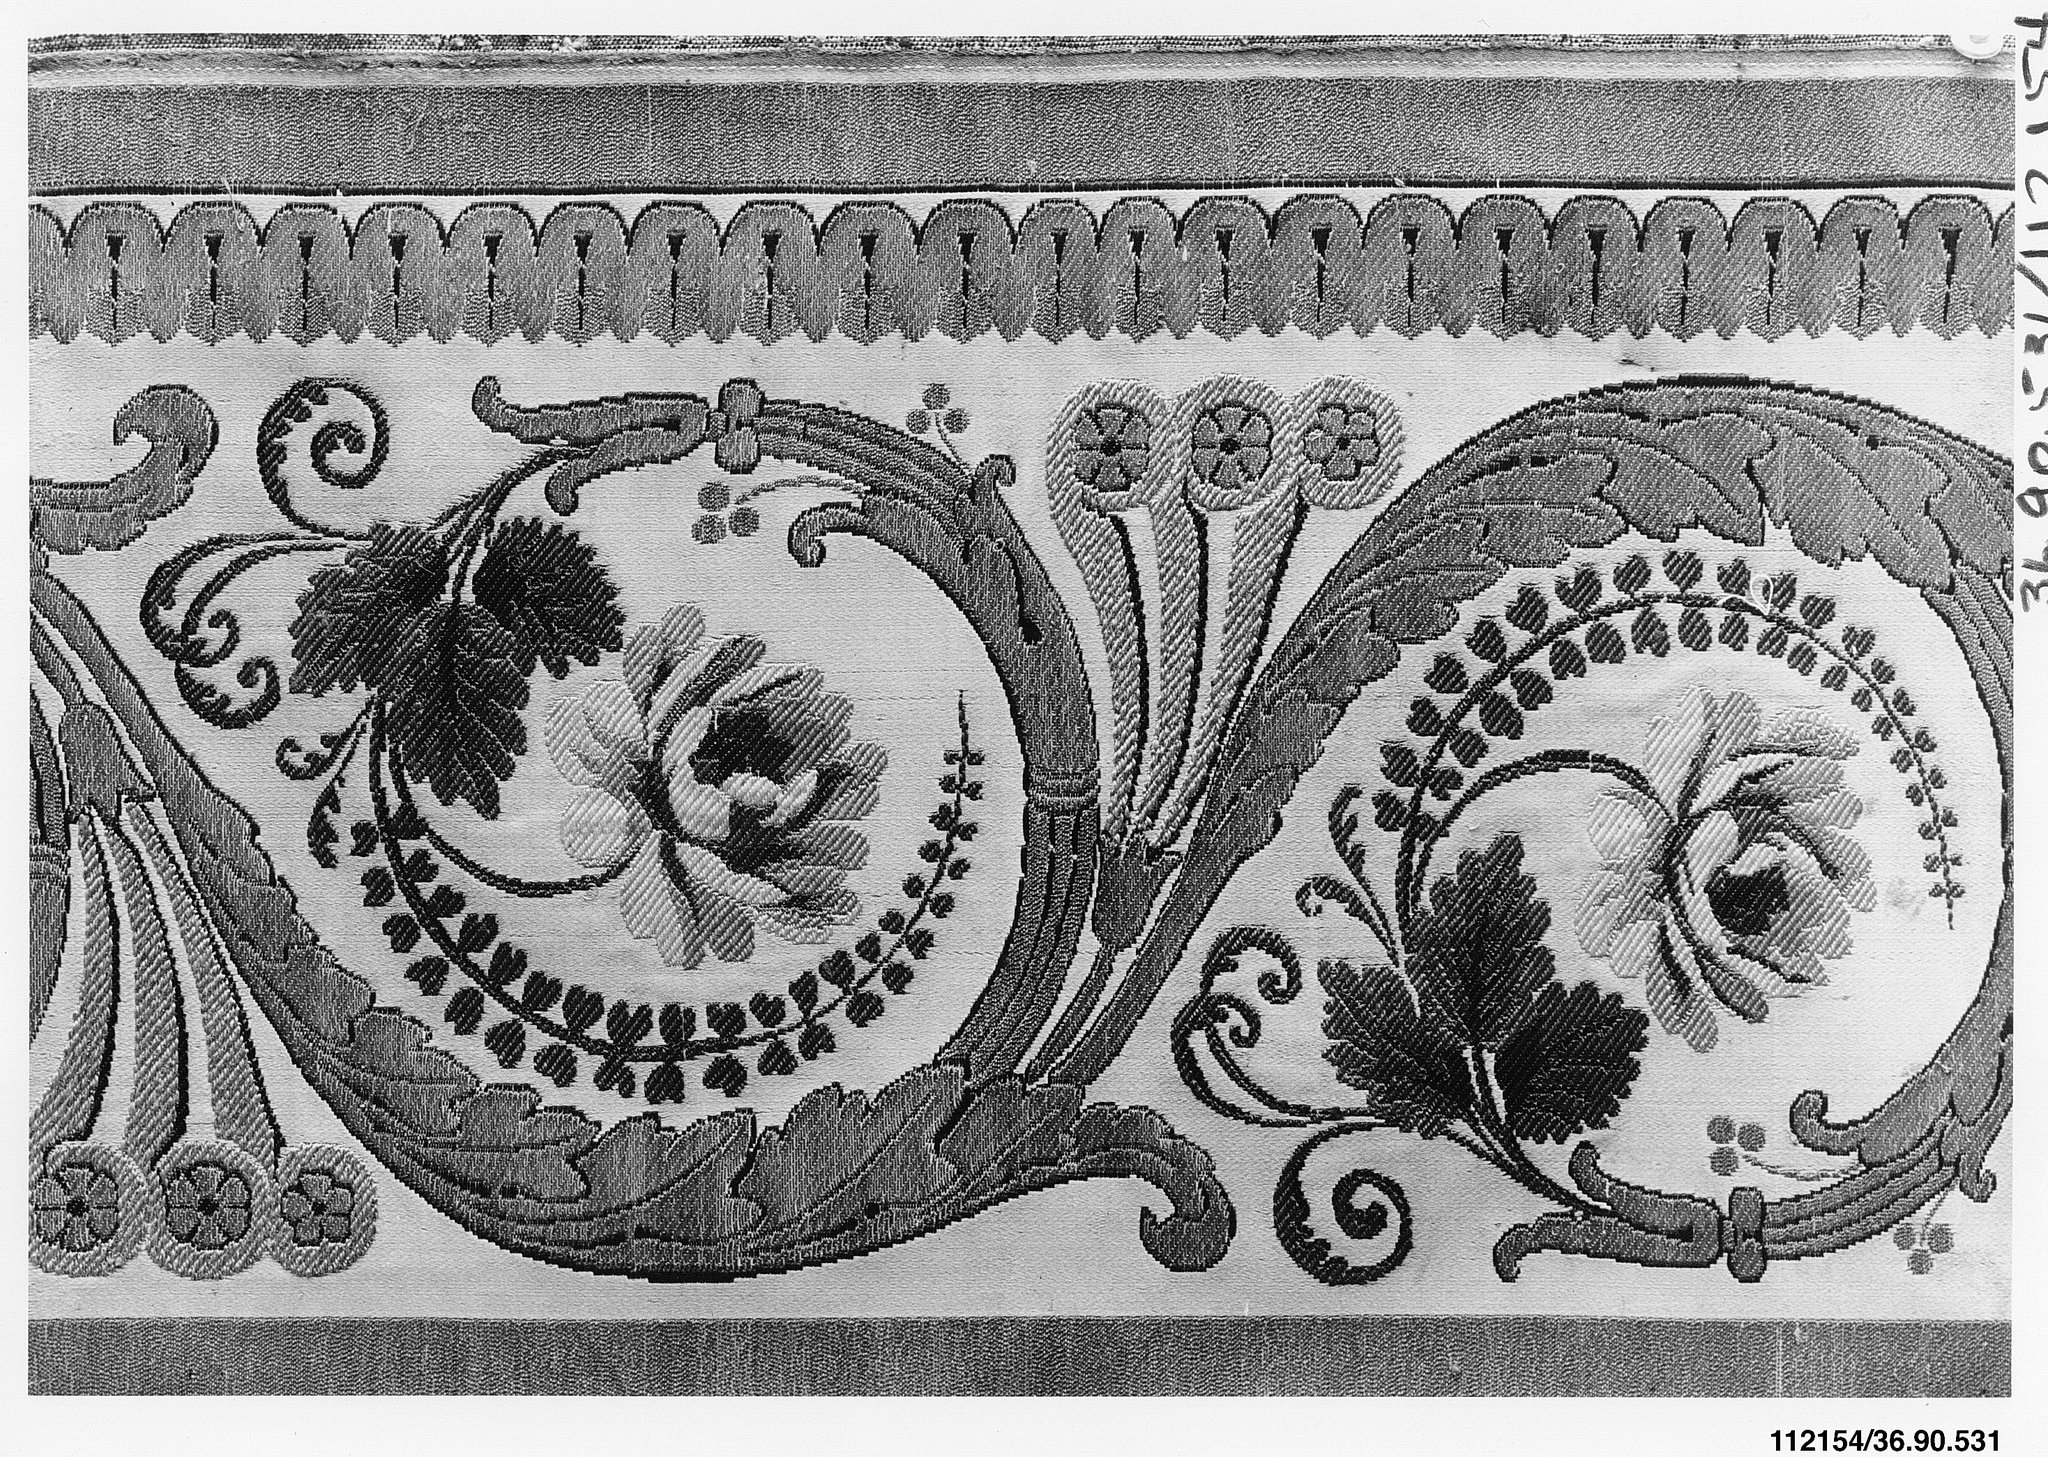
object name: piece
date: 1801-1833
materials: metal thread, silk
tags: flowers,leaves